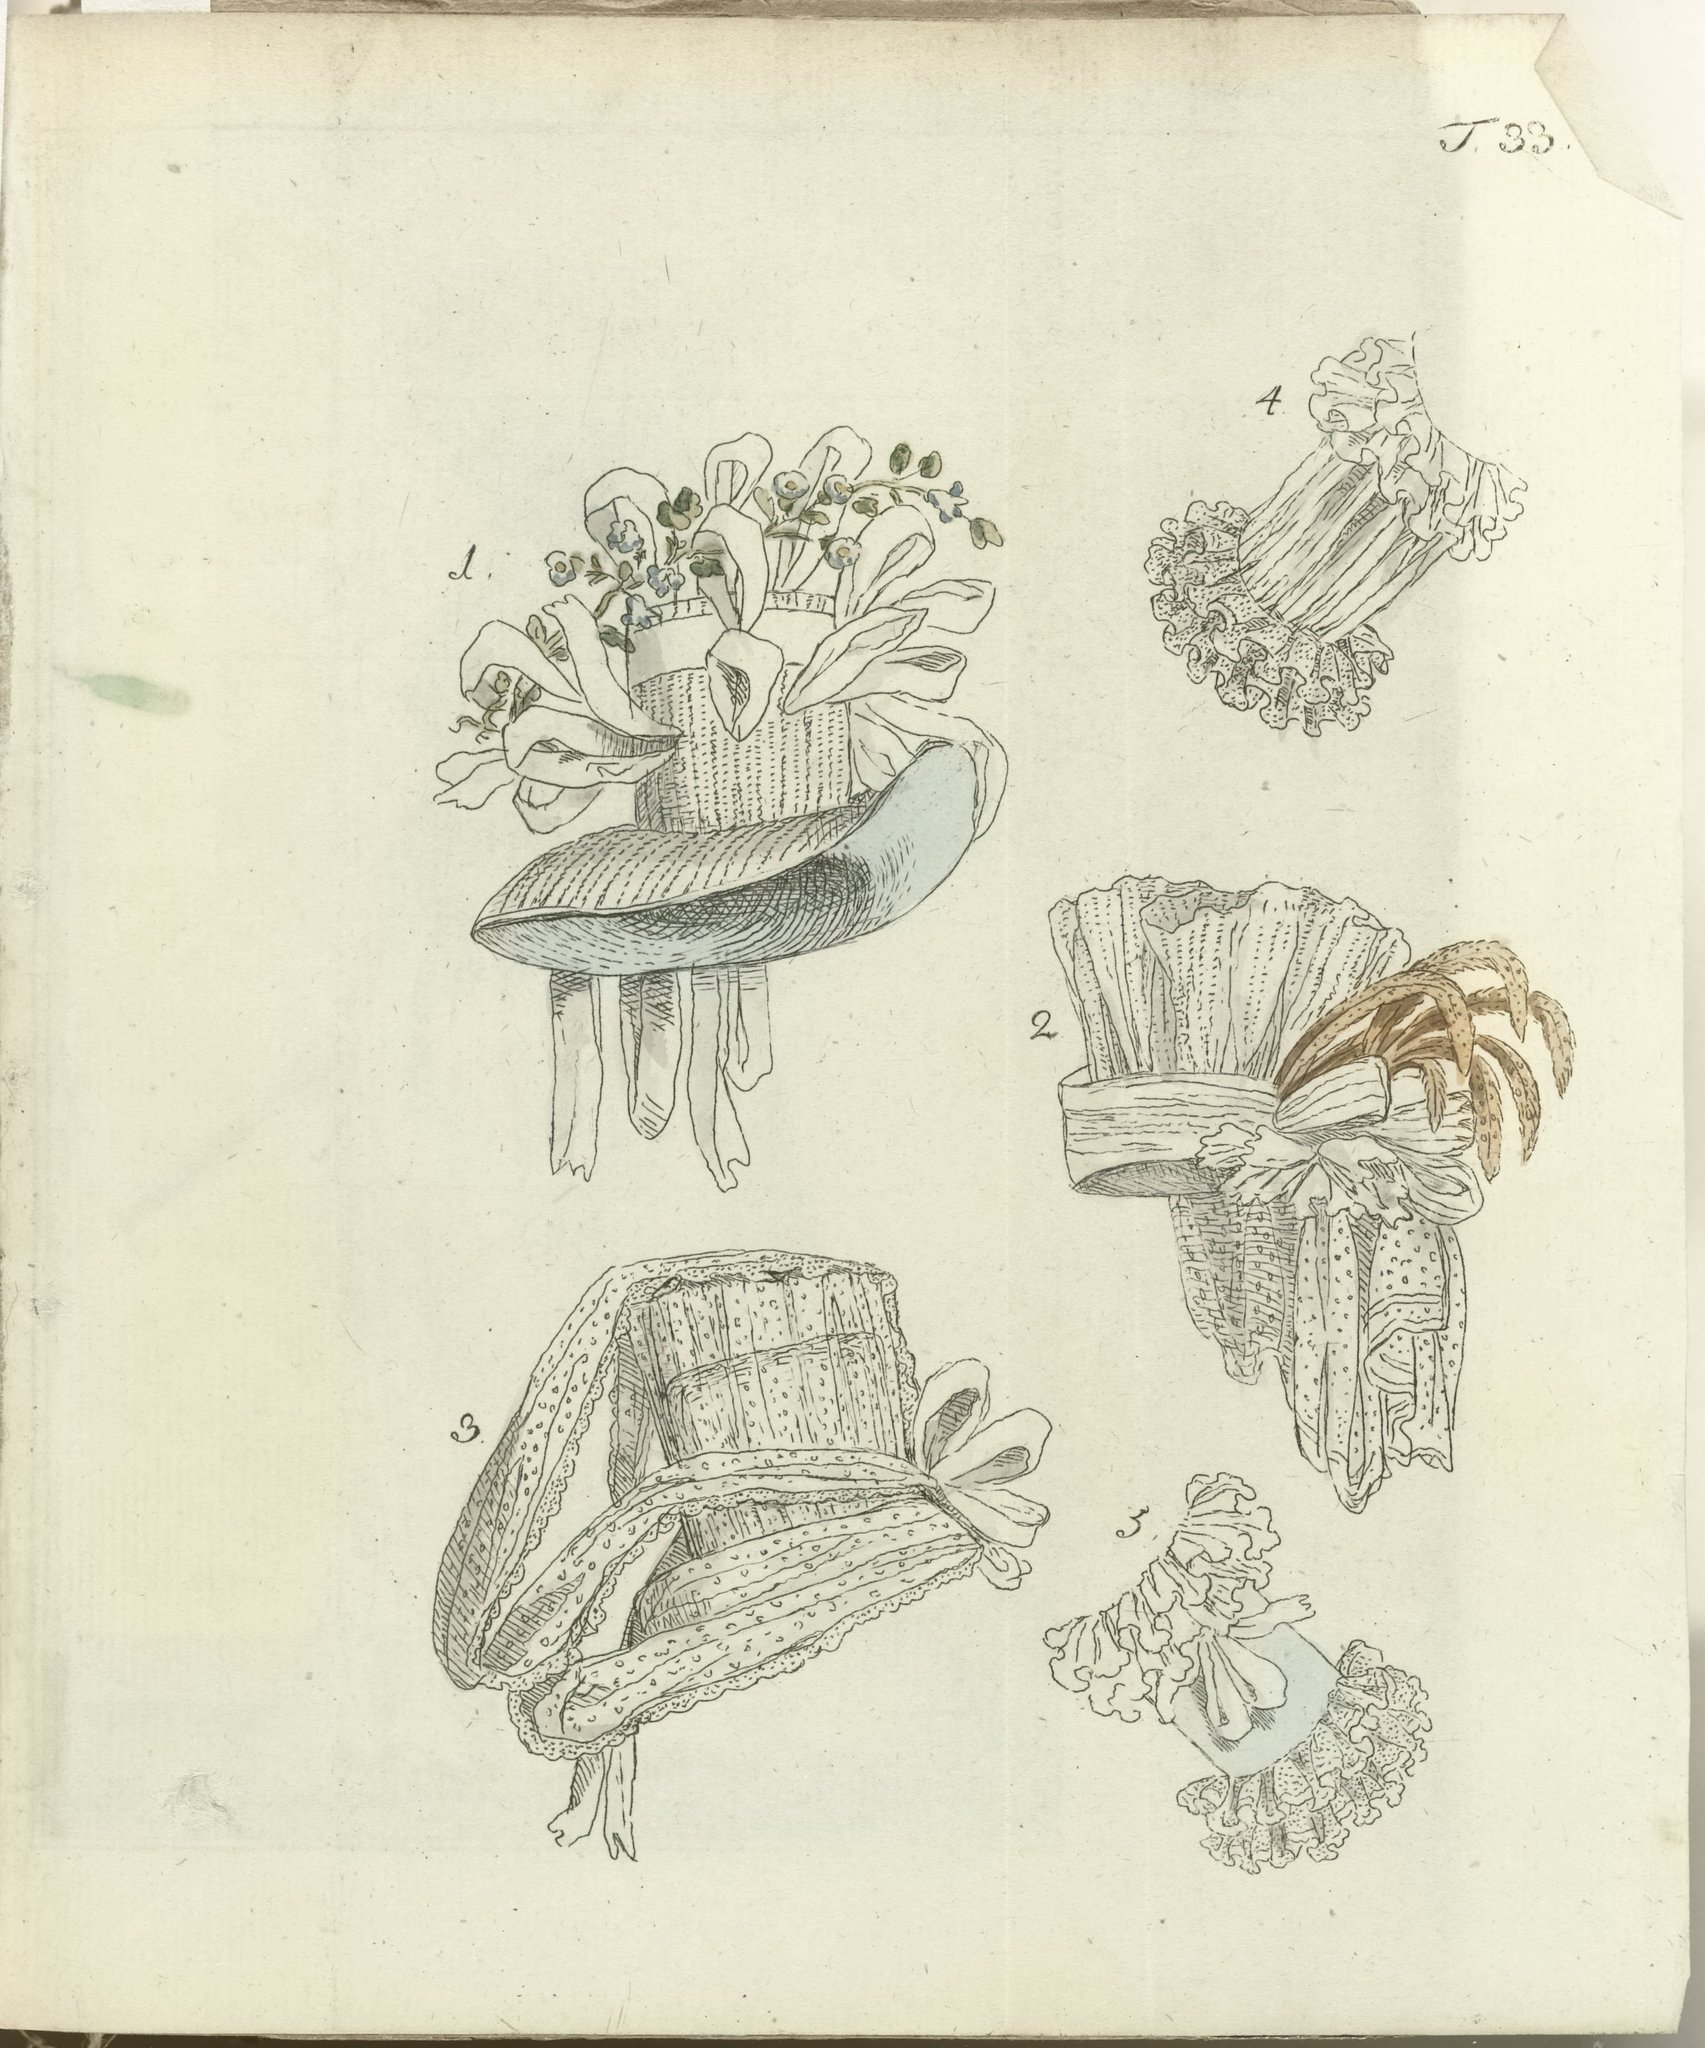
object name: fashion print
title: Journal des Luxus und der Moden 1788, Band III, T.33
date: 1788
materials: paper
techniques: etching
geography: weimar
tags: fashion plates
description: Prent uit het modetijdschrift Journal des Luxus und der Moden, uitgegeven door Friedrich Justin Bertuch en Georg Melchior Kraus, Weimar, 1786-1826.